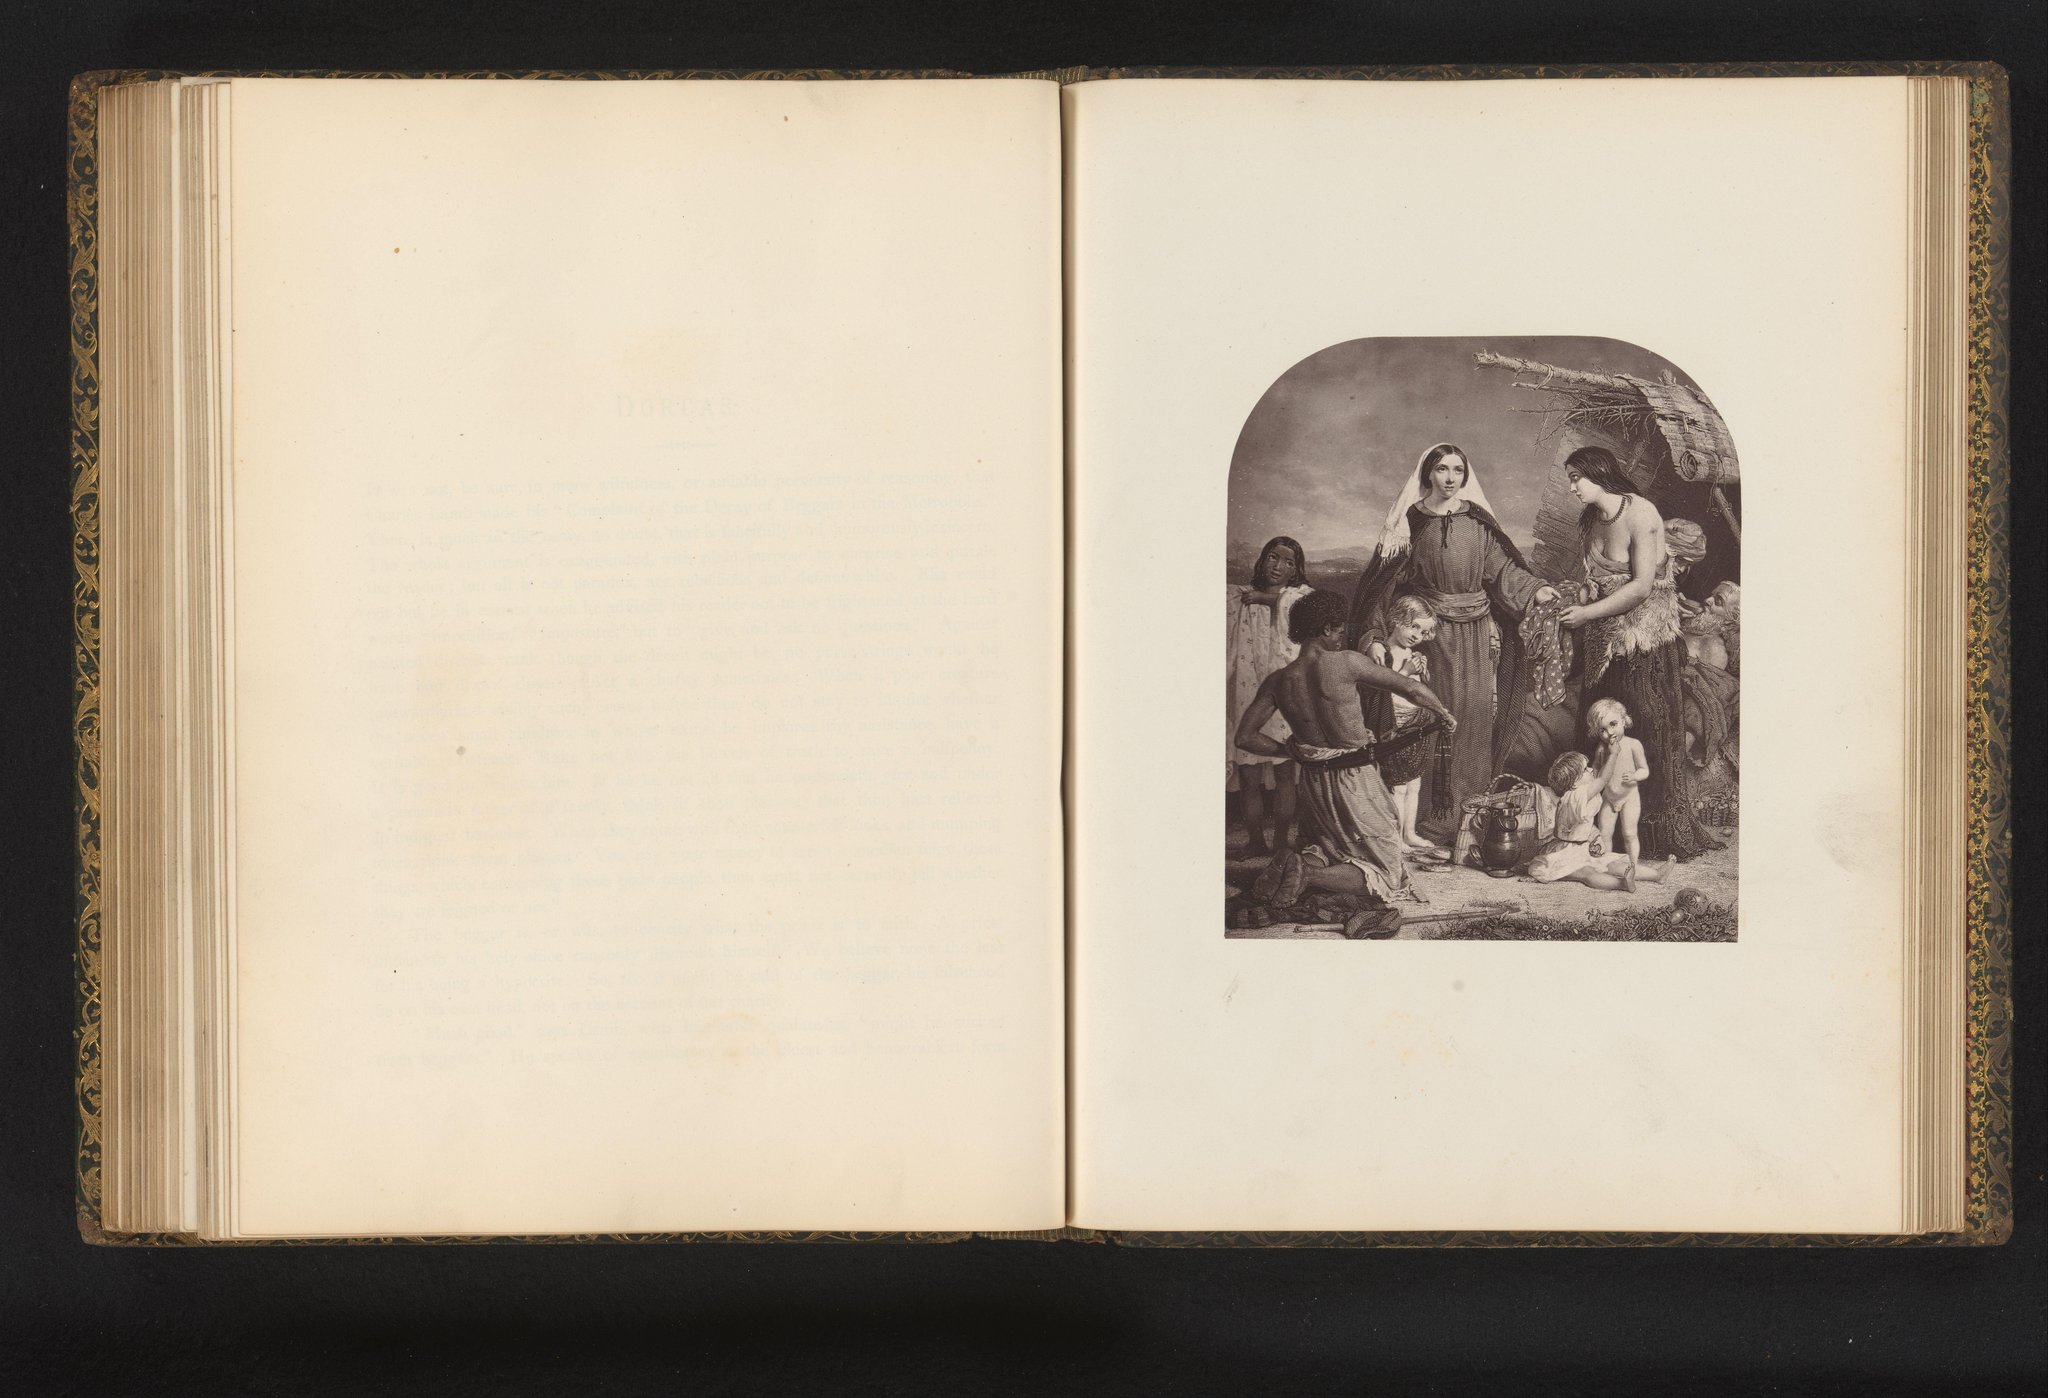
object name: reproduction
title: Fotoreproductie van een gravure naar het schilderij The almsdeed of Dorcas door William Charles Thomas Dobson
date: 1866-1871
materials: paper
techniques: woodburytype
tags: print, e.g.: engraving, etching, lithograph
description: Prent op derde ongenummerde pagina na pagina 104.